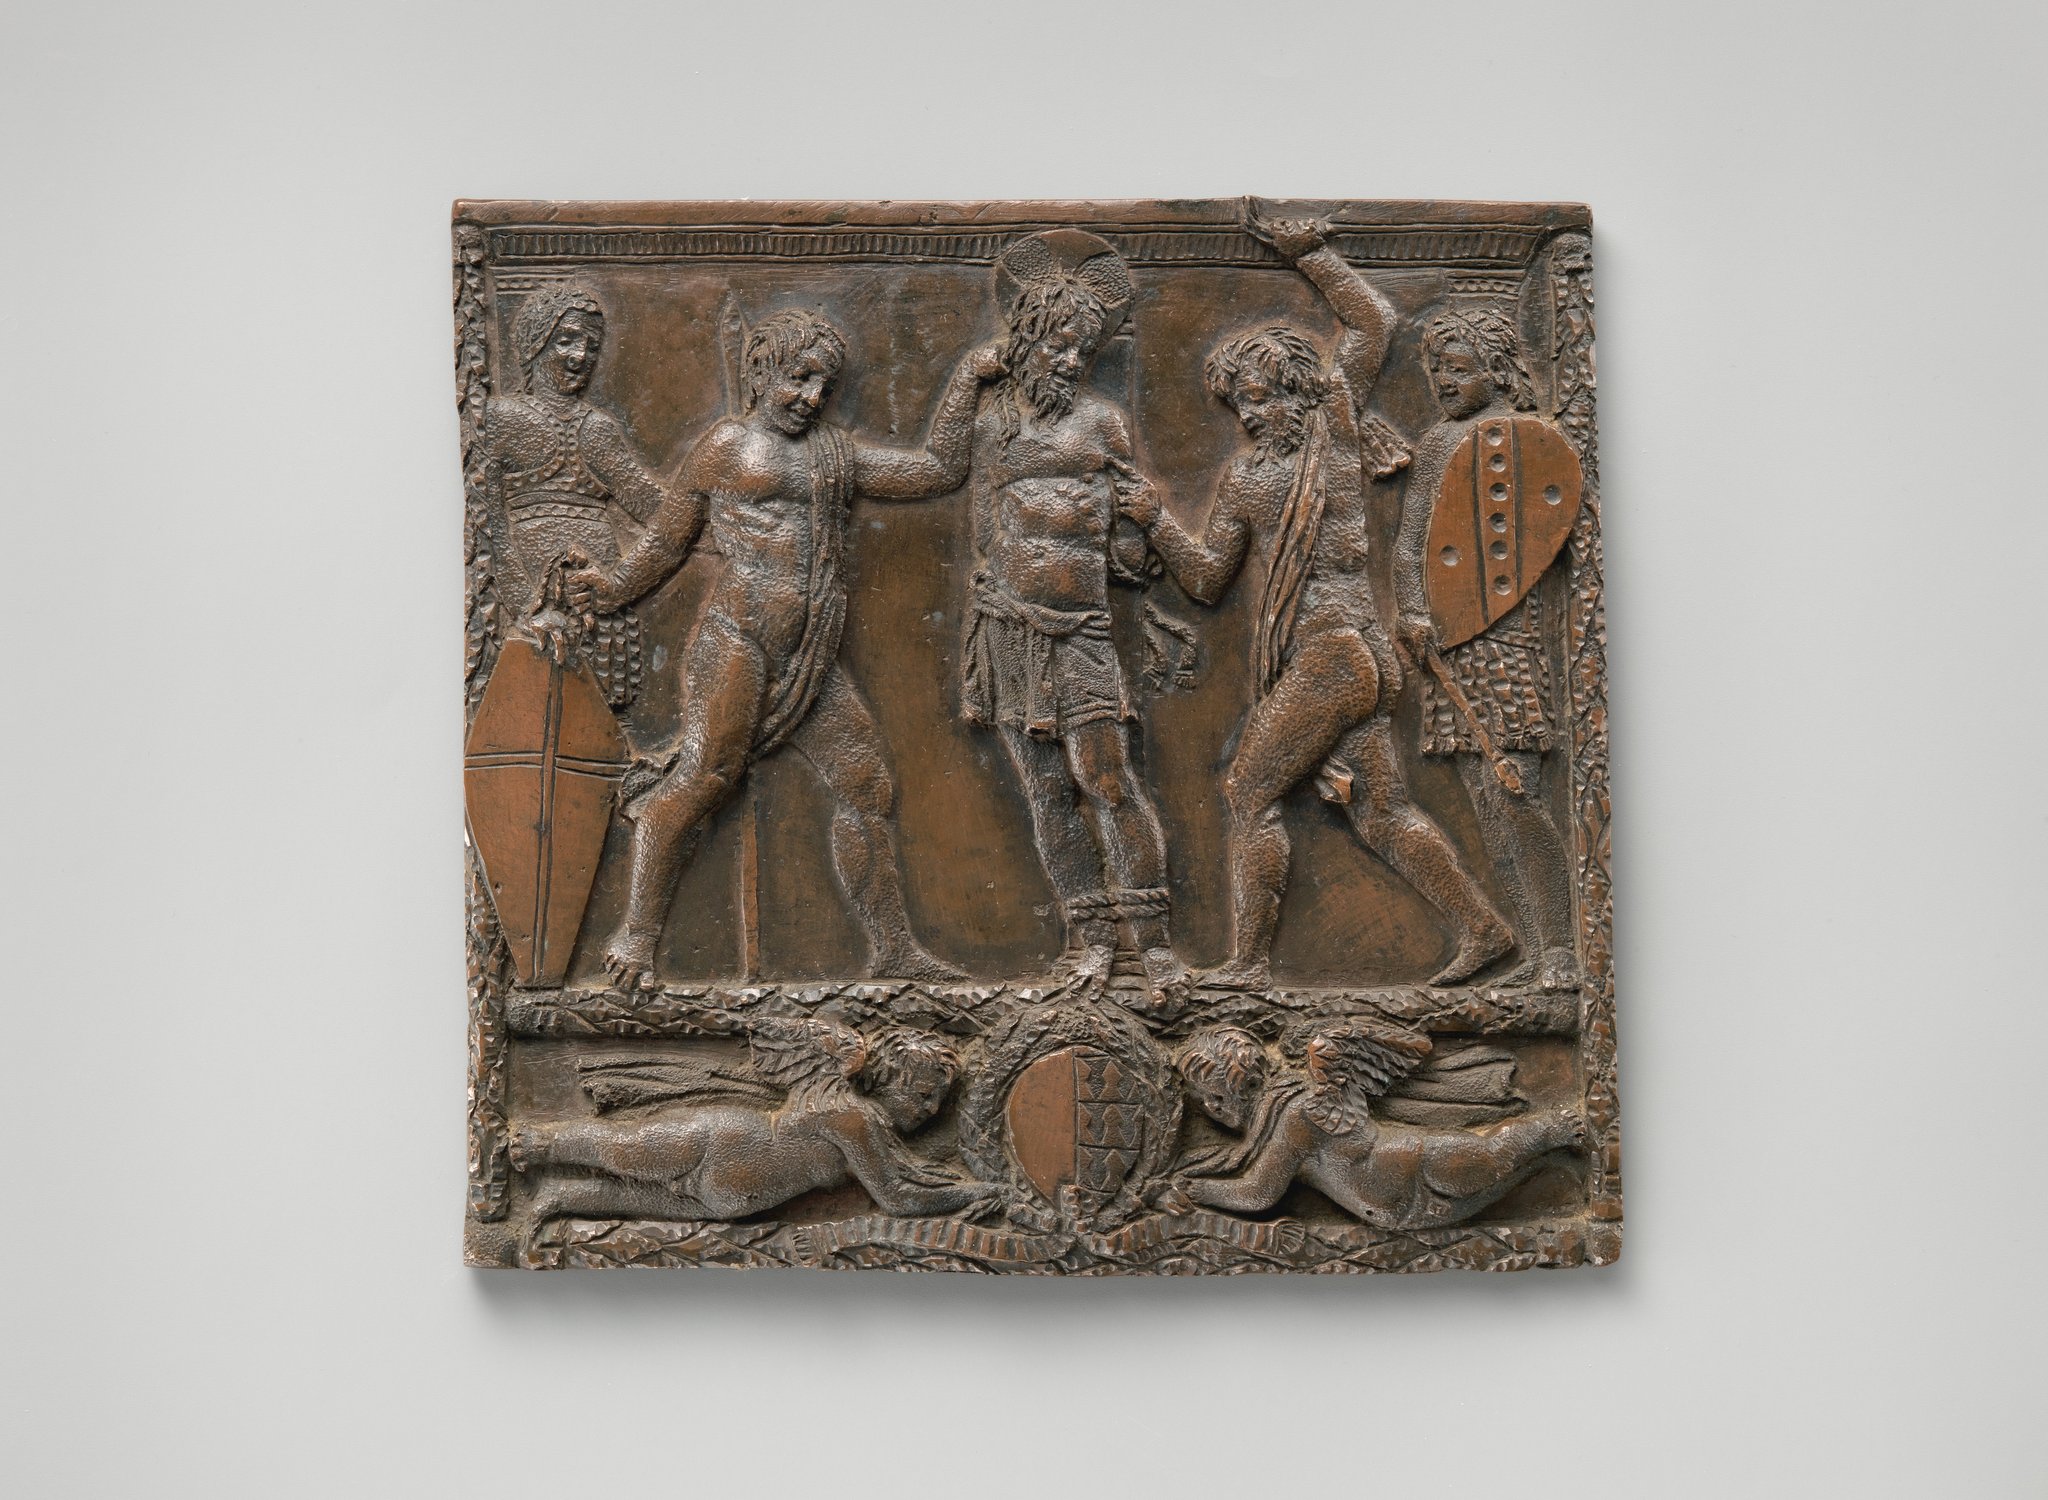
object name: plaque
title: The flagellation of Christ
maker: donatello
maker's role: maker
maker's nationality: italian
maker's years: 1386-1466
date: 1867-1933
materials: bronze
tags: men,putti,christ